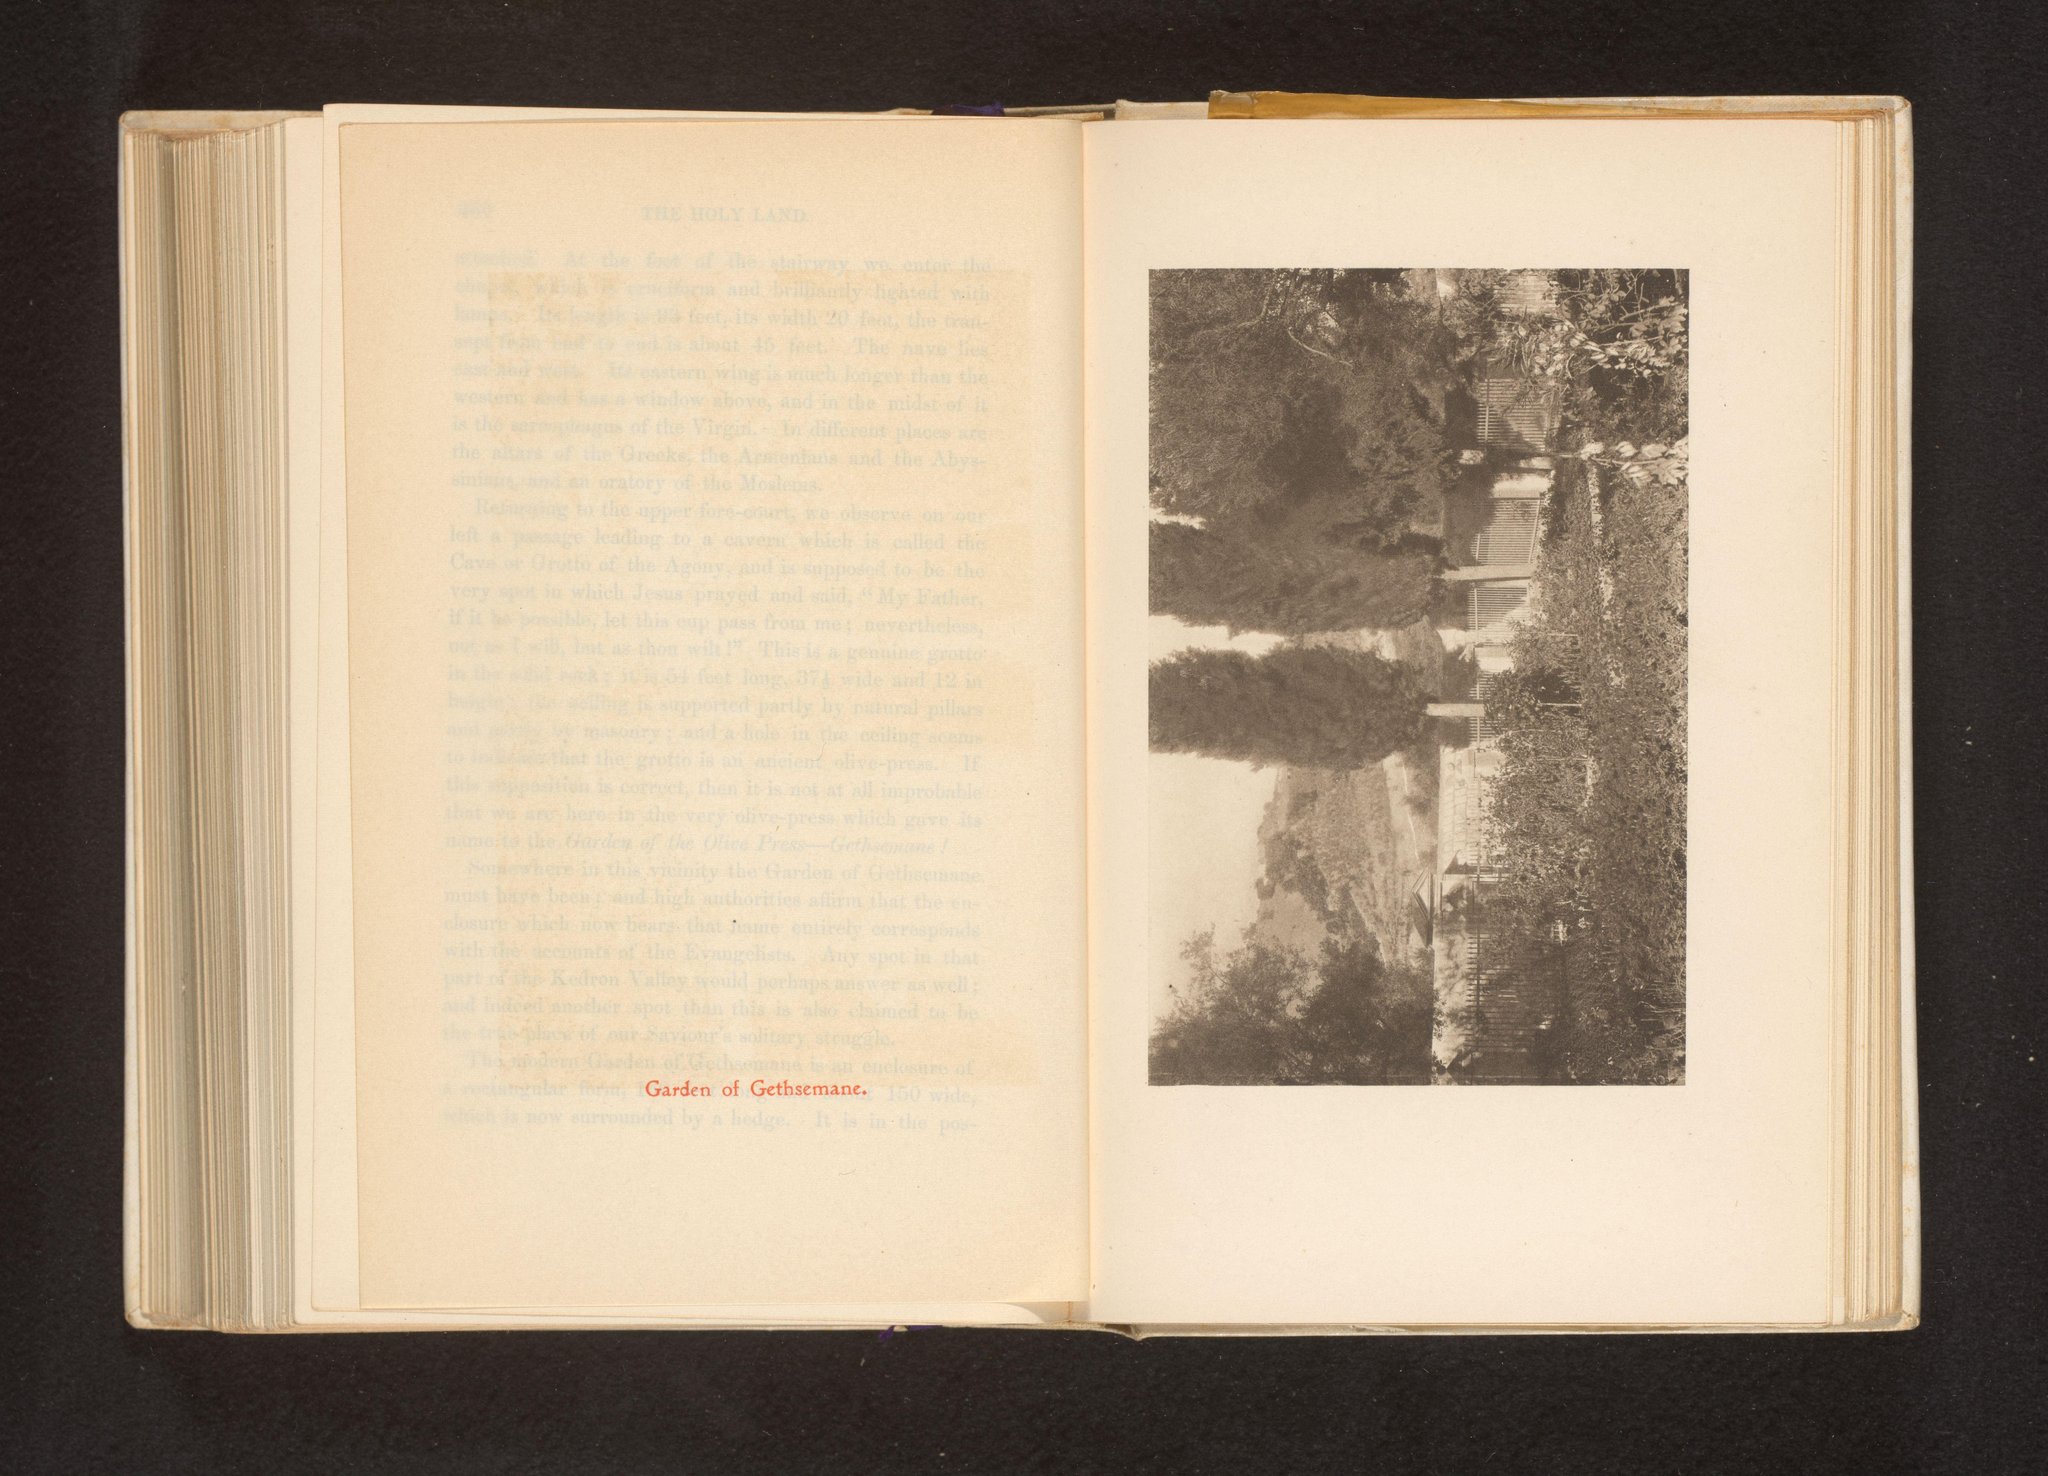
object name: photomechanical print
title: Hof van Getsemane te Jeruzalem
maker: Anonymous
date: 1890-1900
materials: paper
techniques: photoaquatint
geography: getsemane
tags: public gardens, park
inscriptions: title: ‘Garden of Gethsemane.’